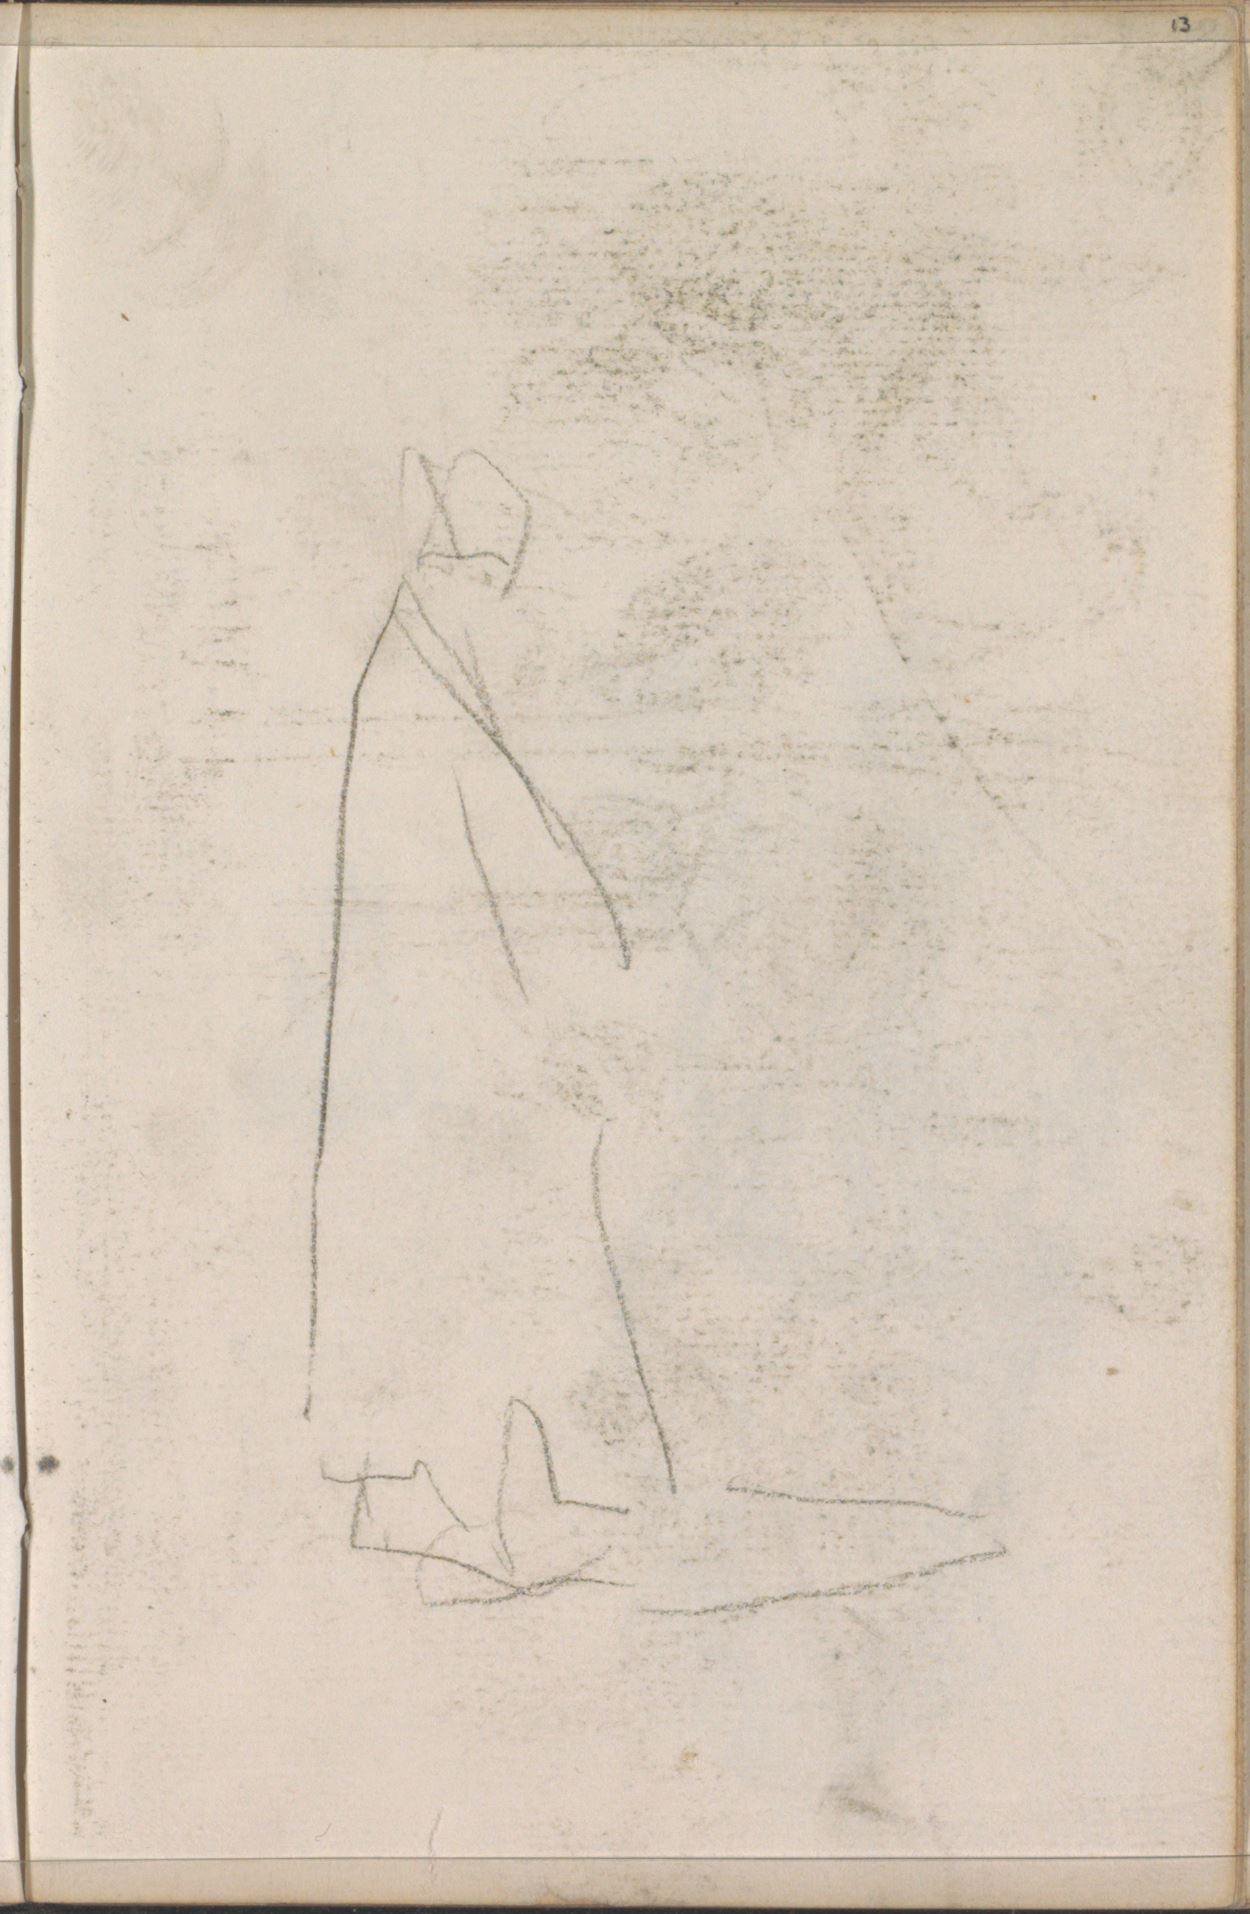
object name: sketchbook leaf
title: Staande figuur in oosterse kleding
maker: marius bauer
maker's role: draughtsman, print maker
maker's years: 1867-1932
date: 1899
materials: chalk, paper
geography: turkey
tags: asiatic races and peoples, standing figure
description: Pagina 13 uit een schetsboek met 42 bladen.